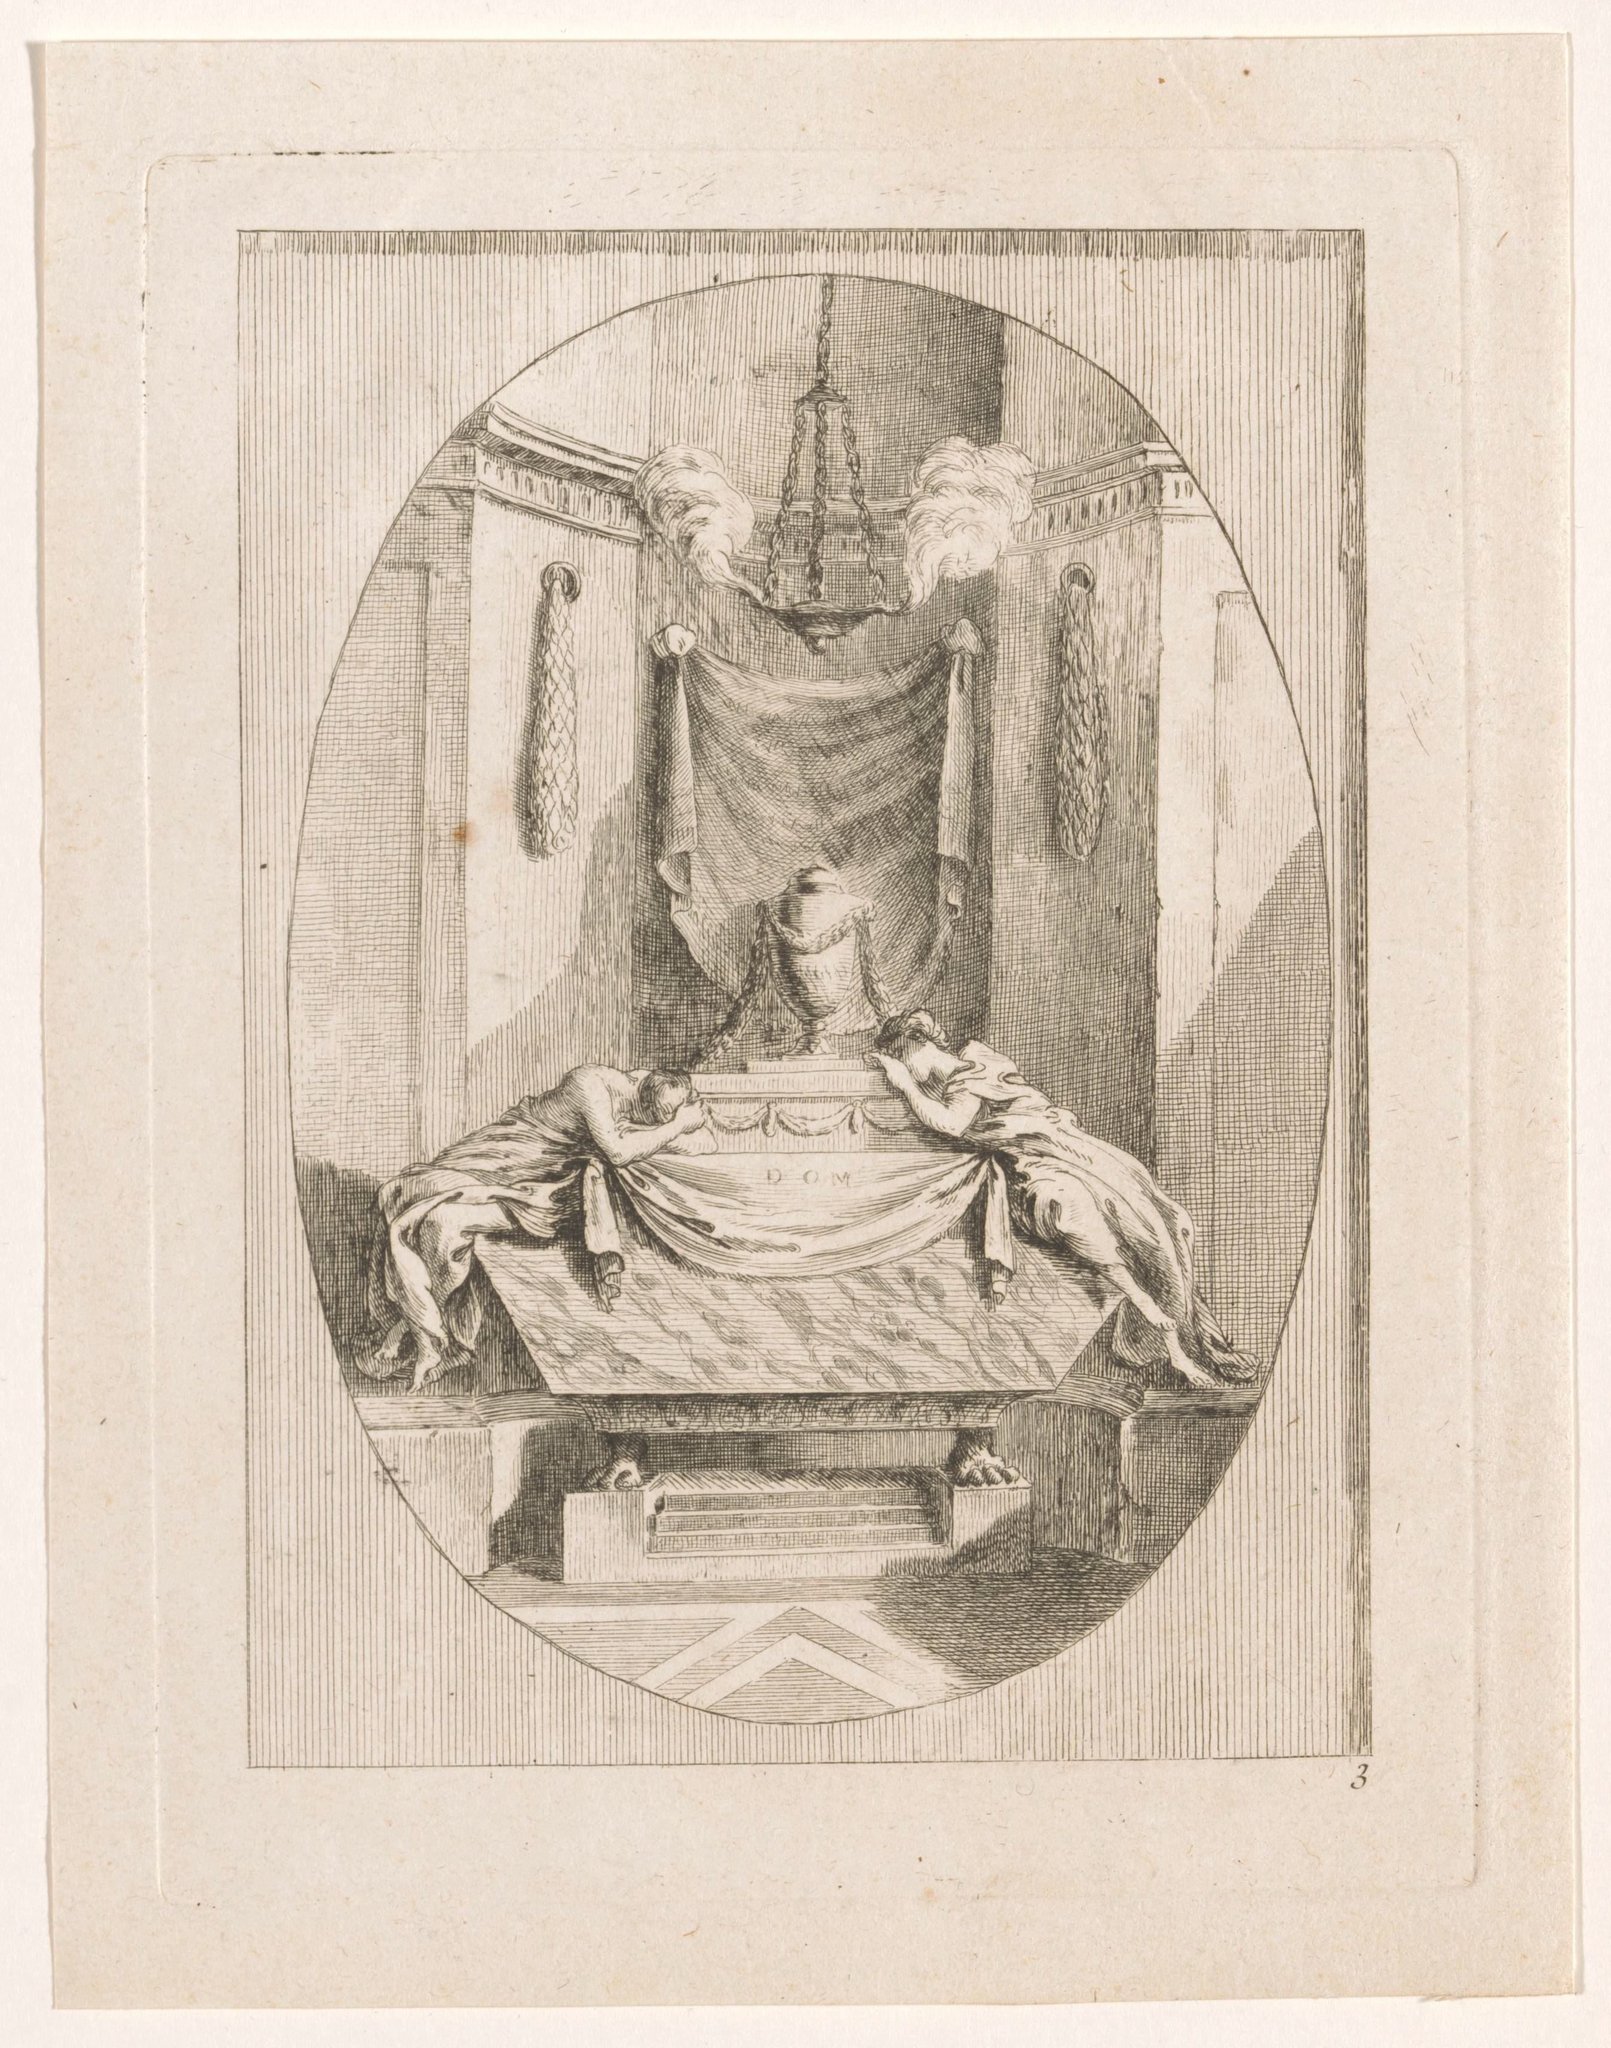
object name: print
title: Tombe met treurende figuren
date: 1755-1782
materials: paper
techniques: etching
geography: paris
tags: incense-burner ~ scents, perfumes, façade (of house or building)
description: Een tombe op leeuwenpoten met een treurende man en vrouw, daarboven hangt een rookvat.